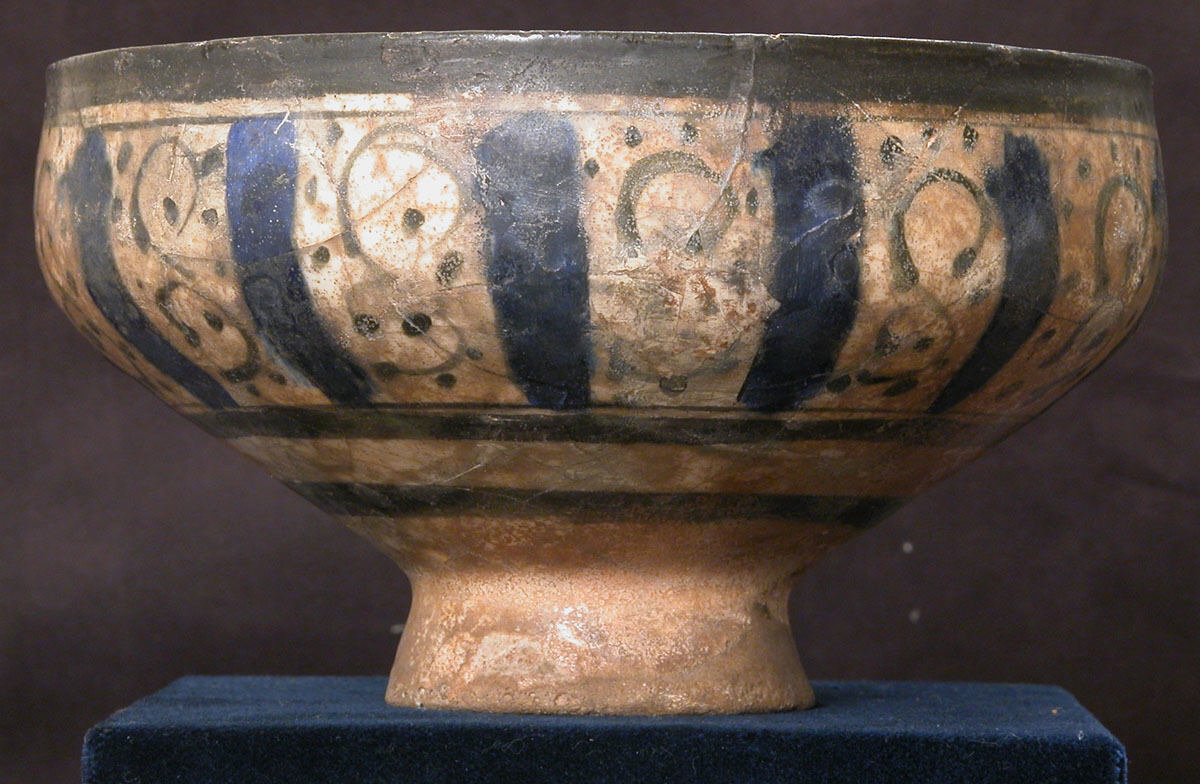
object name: bowl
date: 1101-1200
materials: glaze, stonepaste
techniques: painting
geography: iran